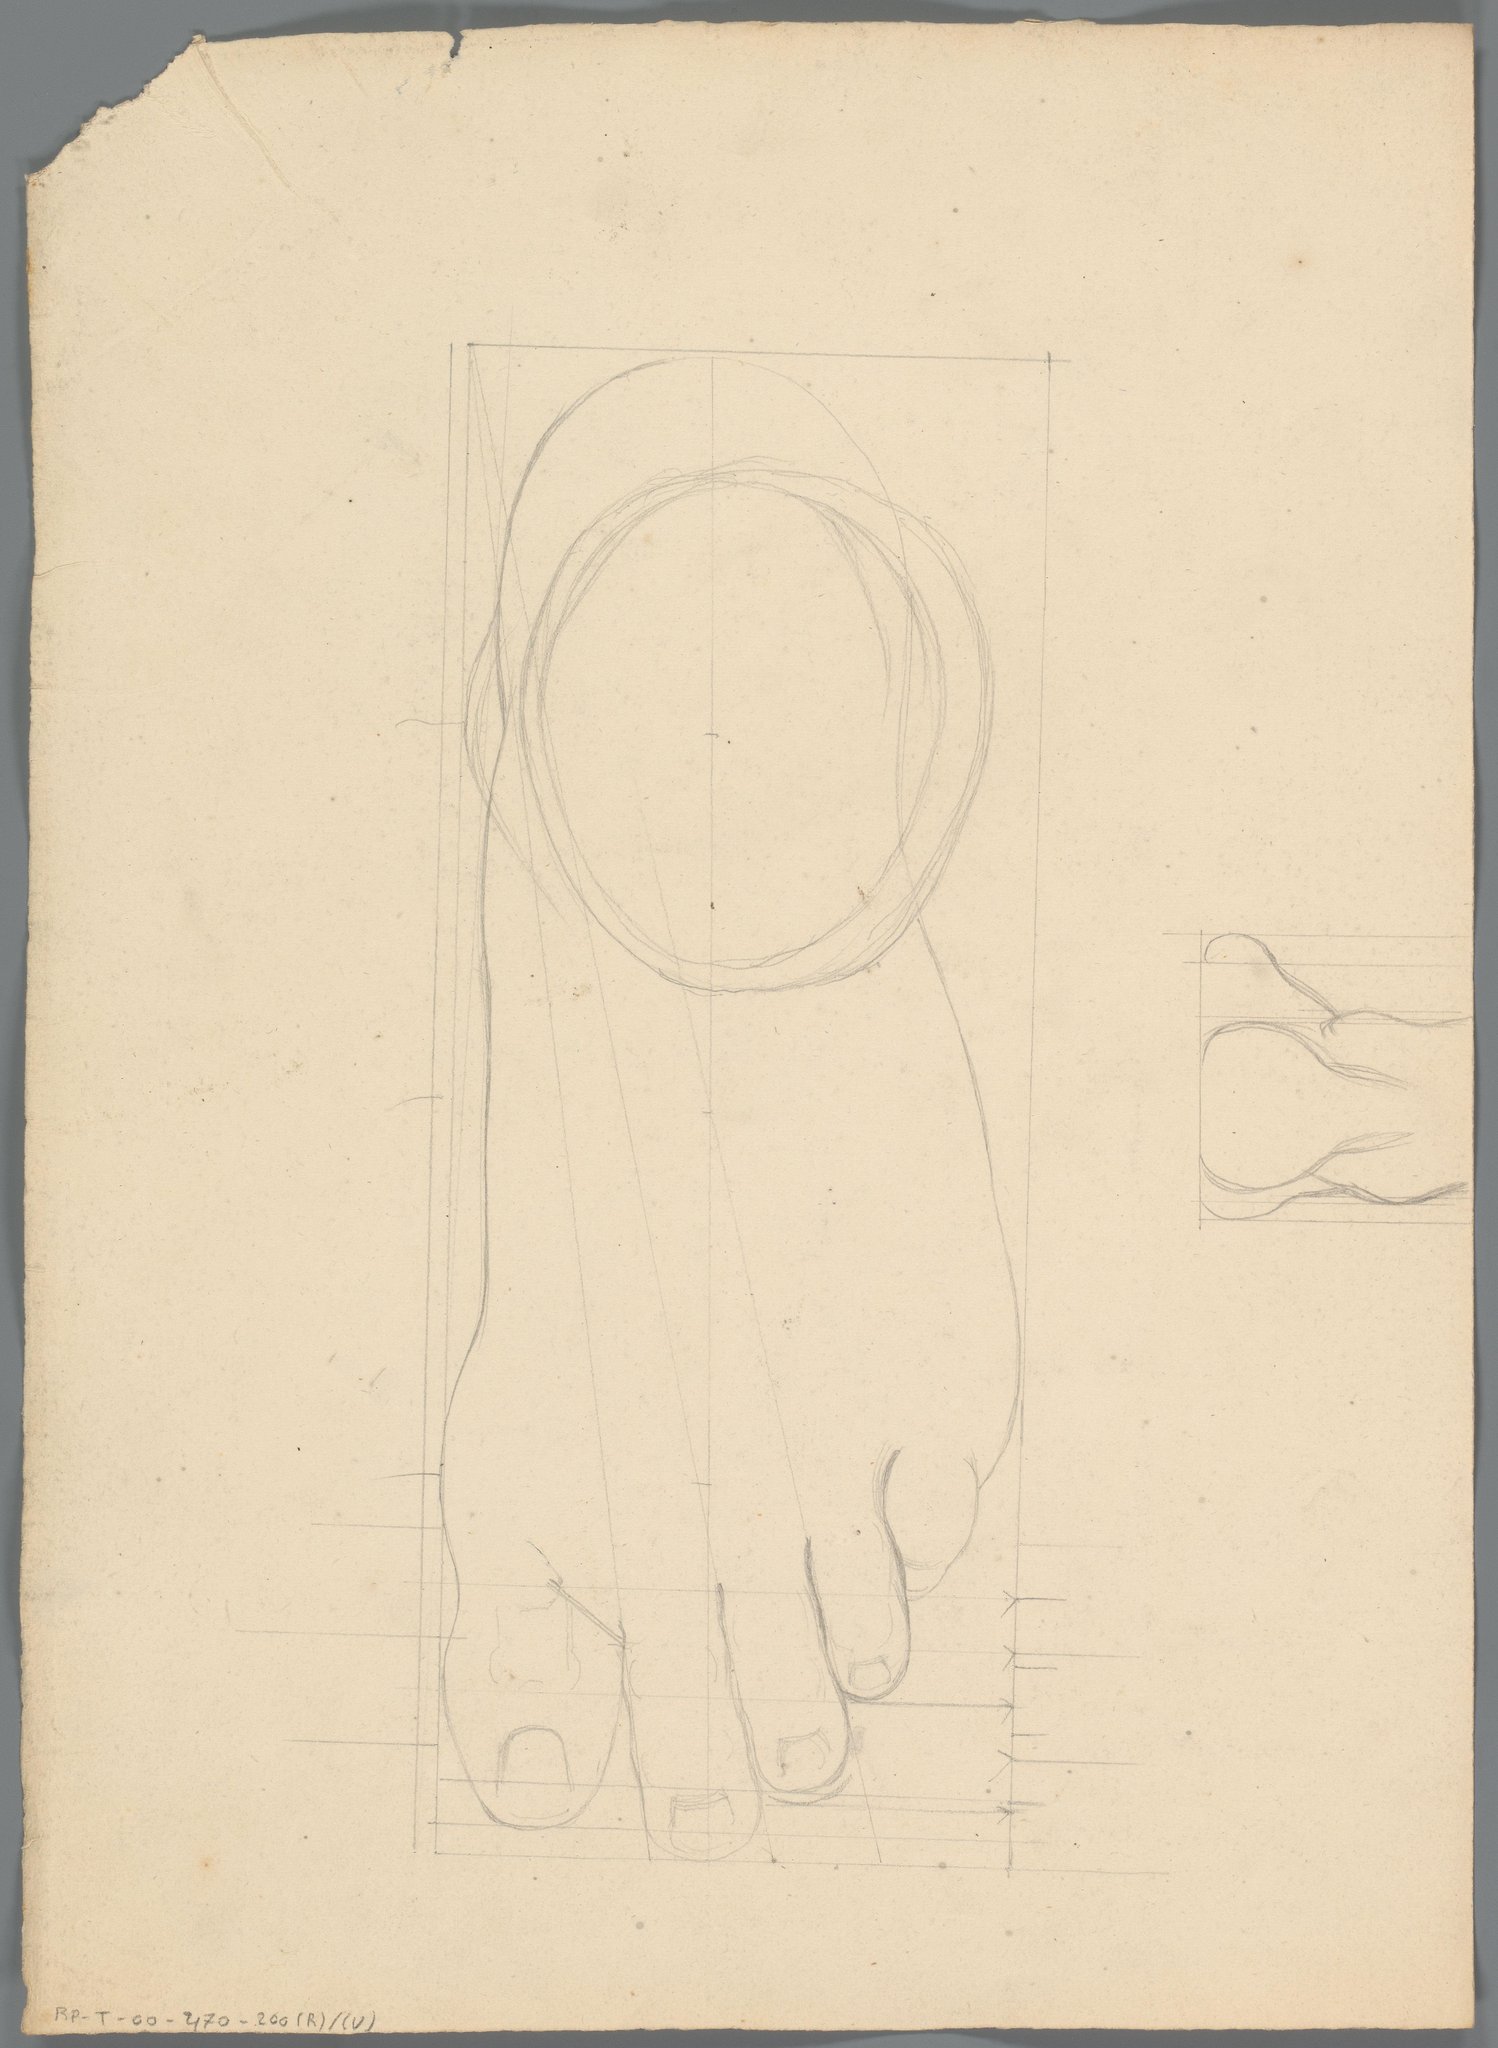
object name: drawing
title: Anatomische studie van een voet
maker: jacobus everhardus josephus van den berg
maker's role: draughtsman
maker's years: 1802-1861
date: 1812-1861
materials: paper, pencil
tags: foot